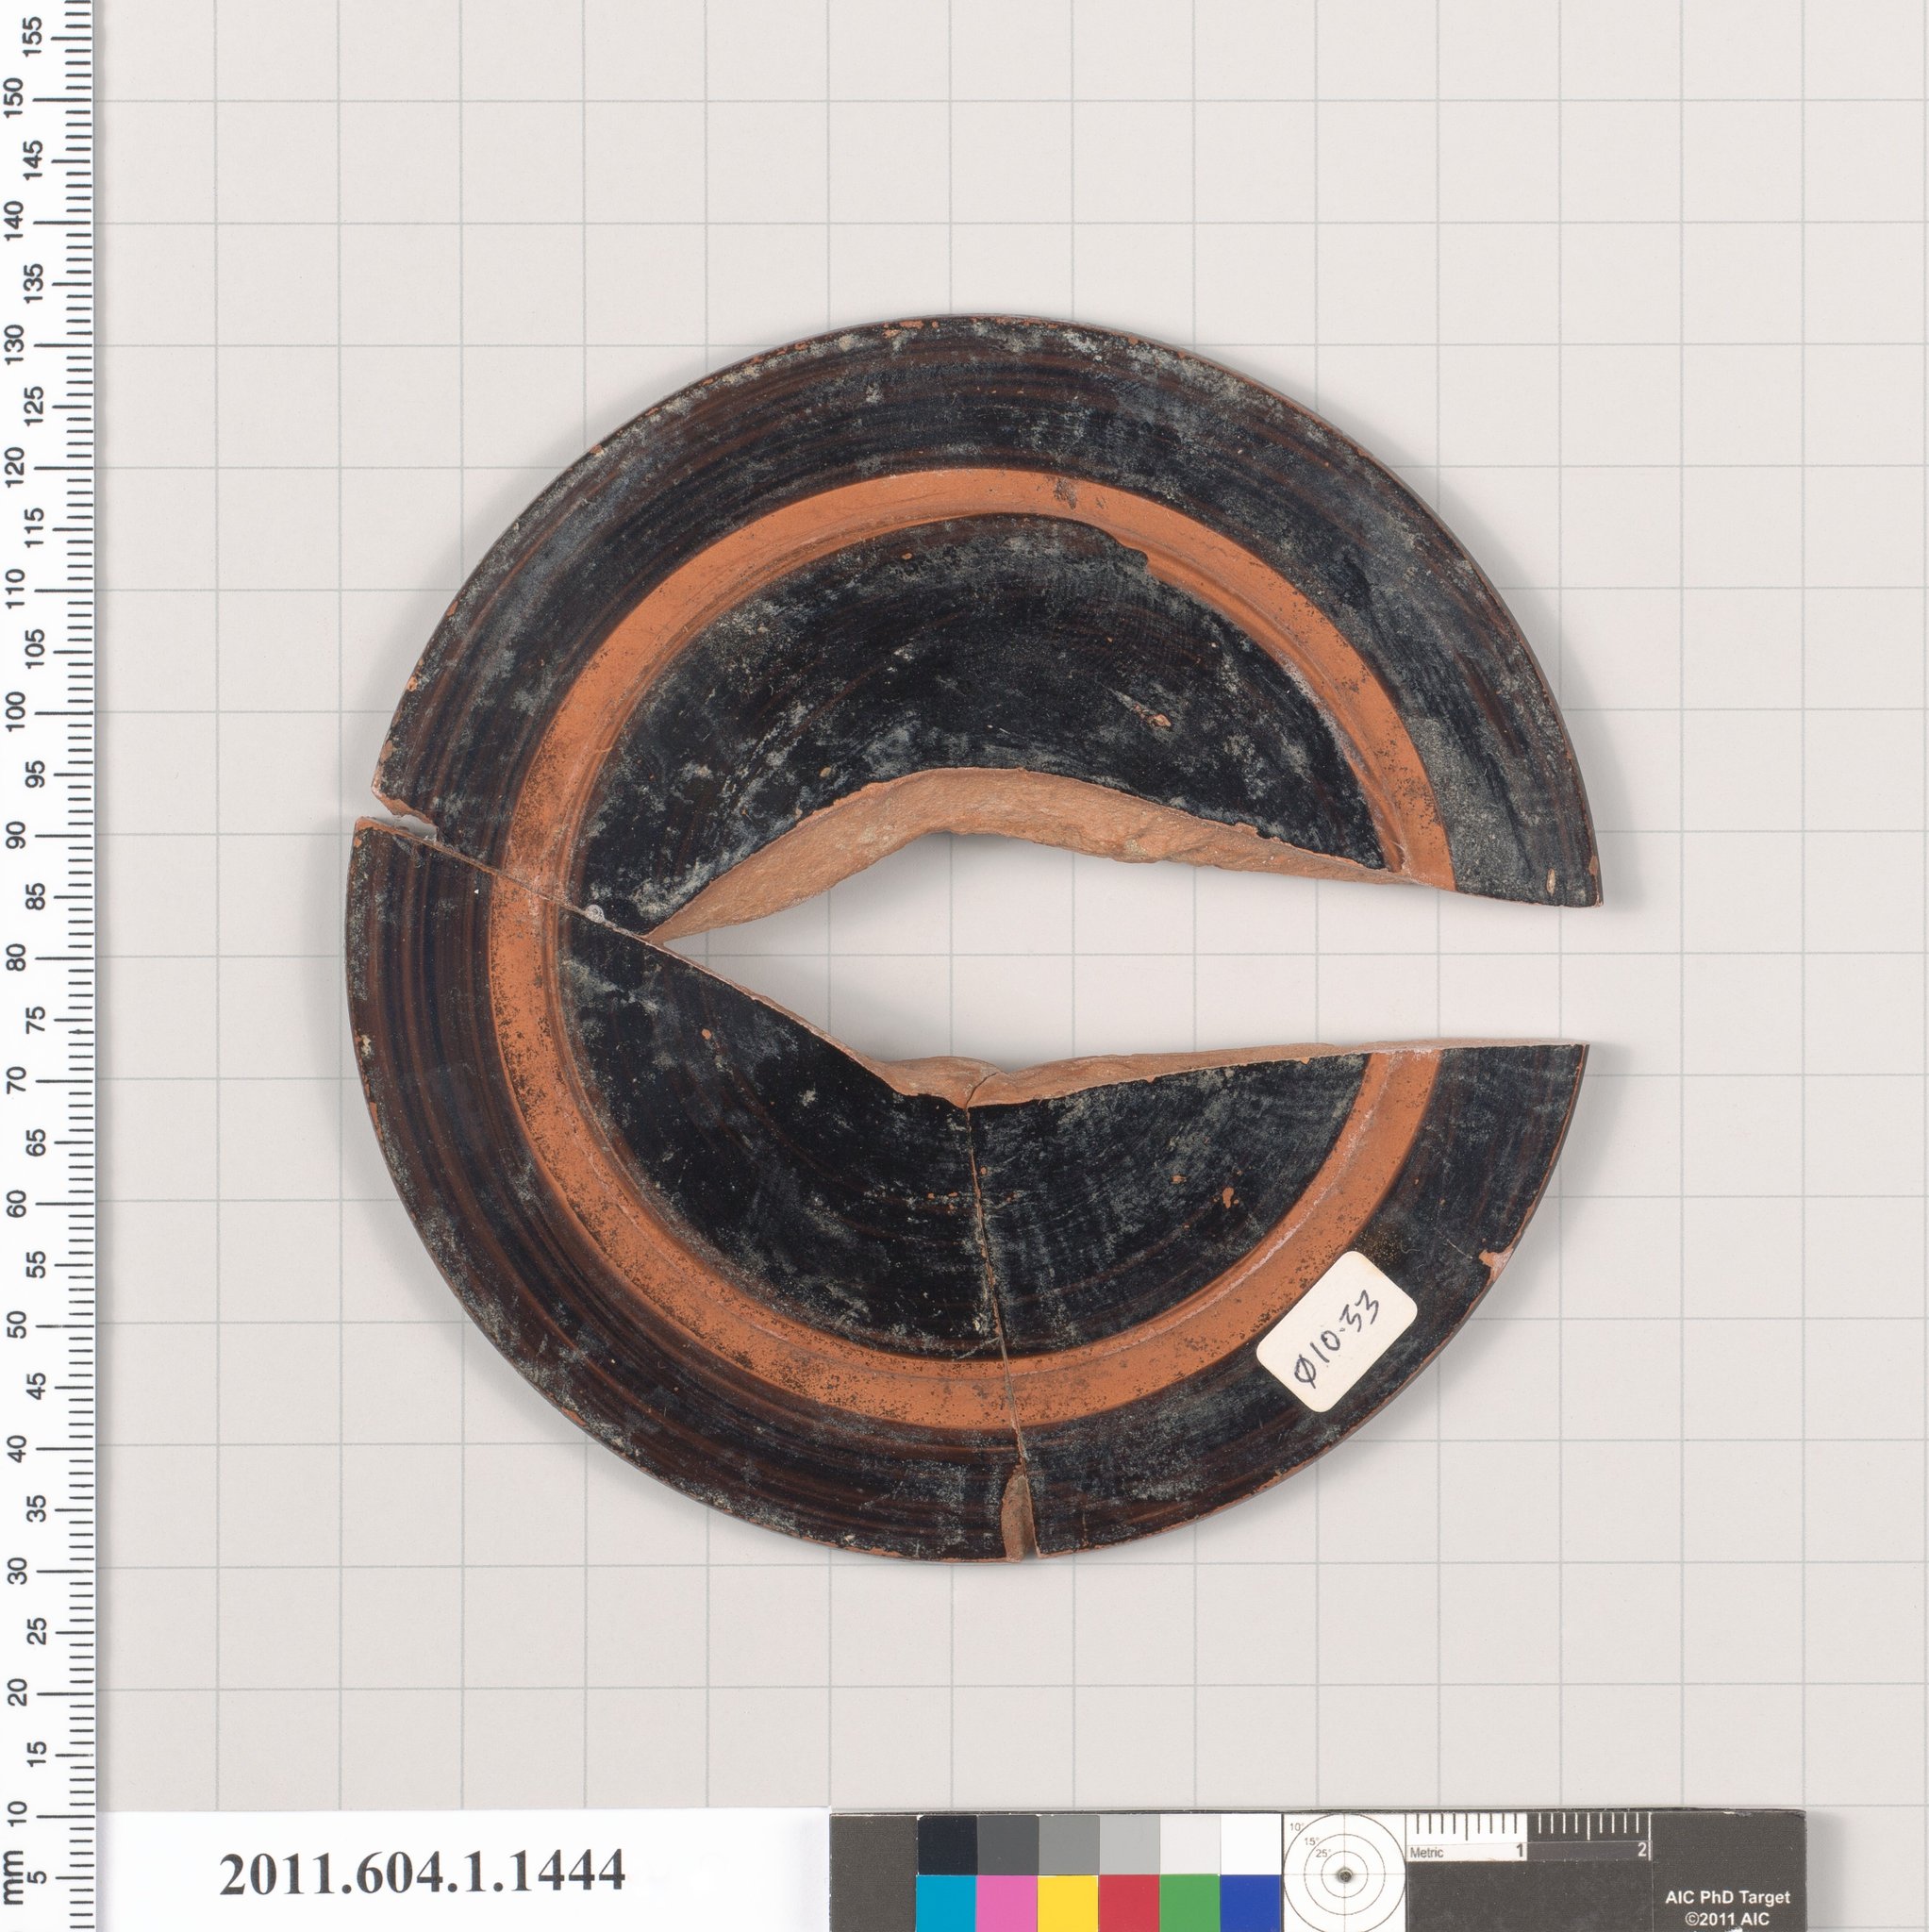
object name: kylix fragment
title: Terracotta fragments of a kylix (drinking cup)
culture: greek, attic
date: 500-401 BCE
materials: terracotta